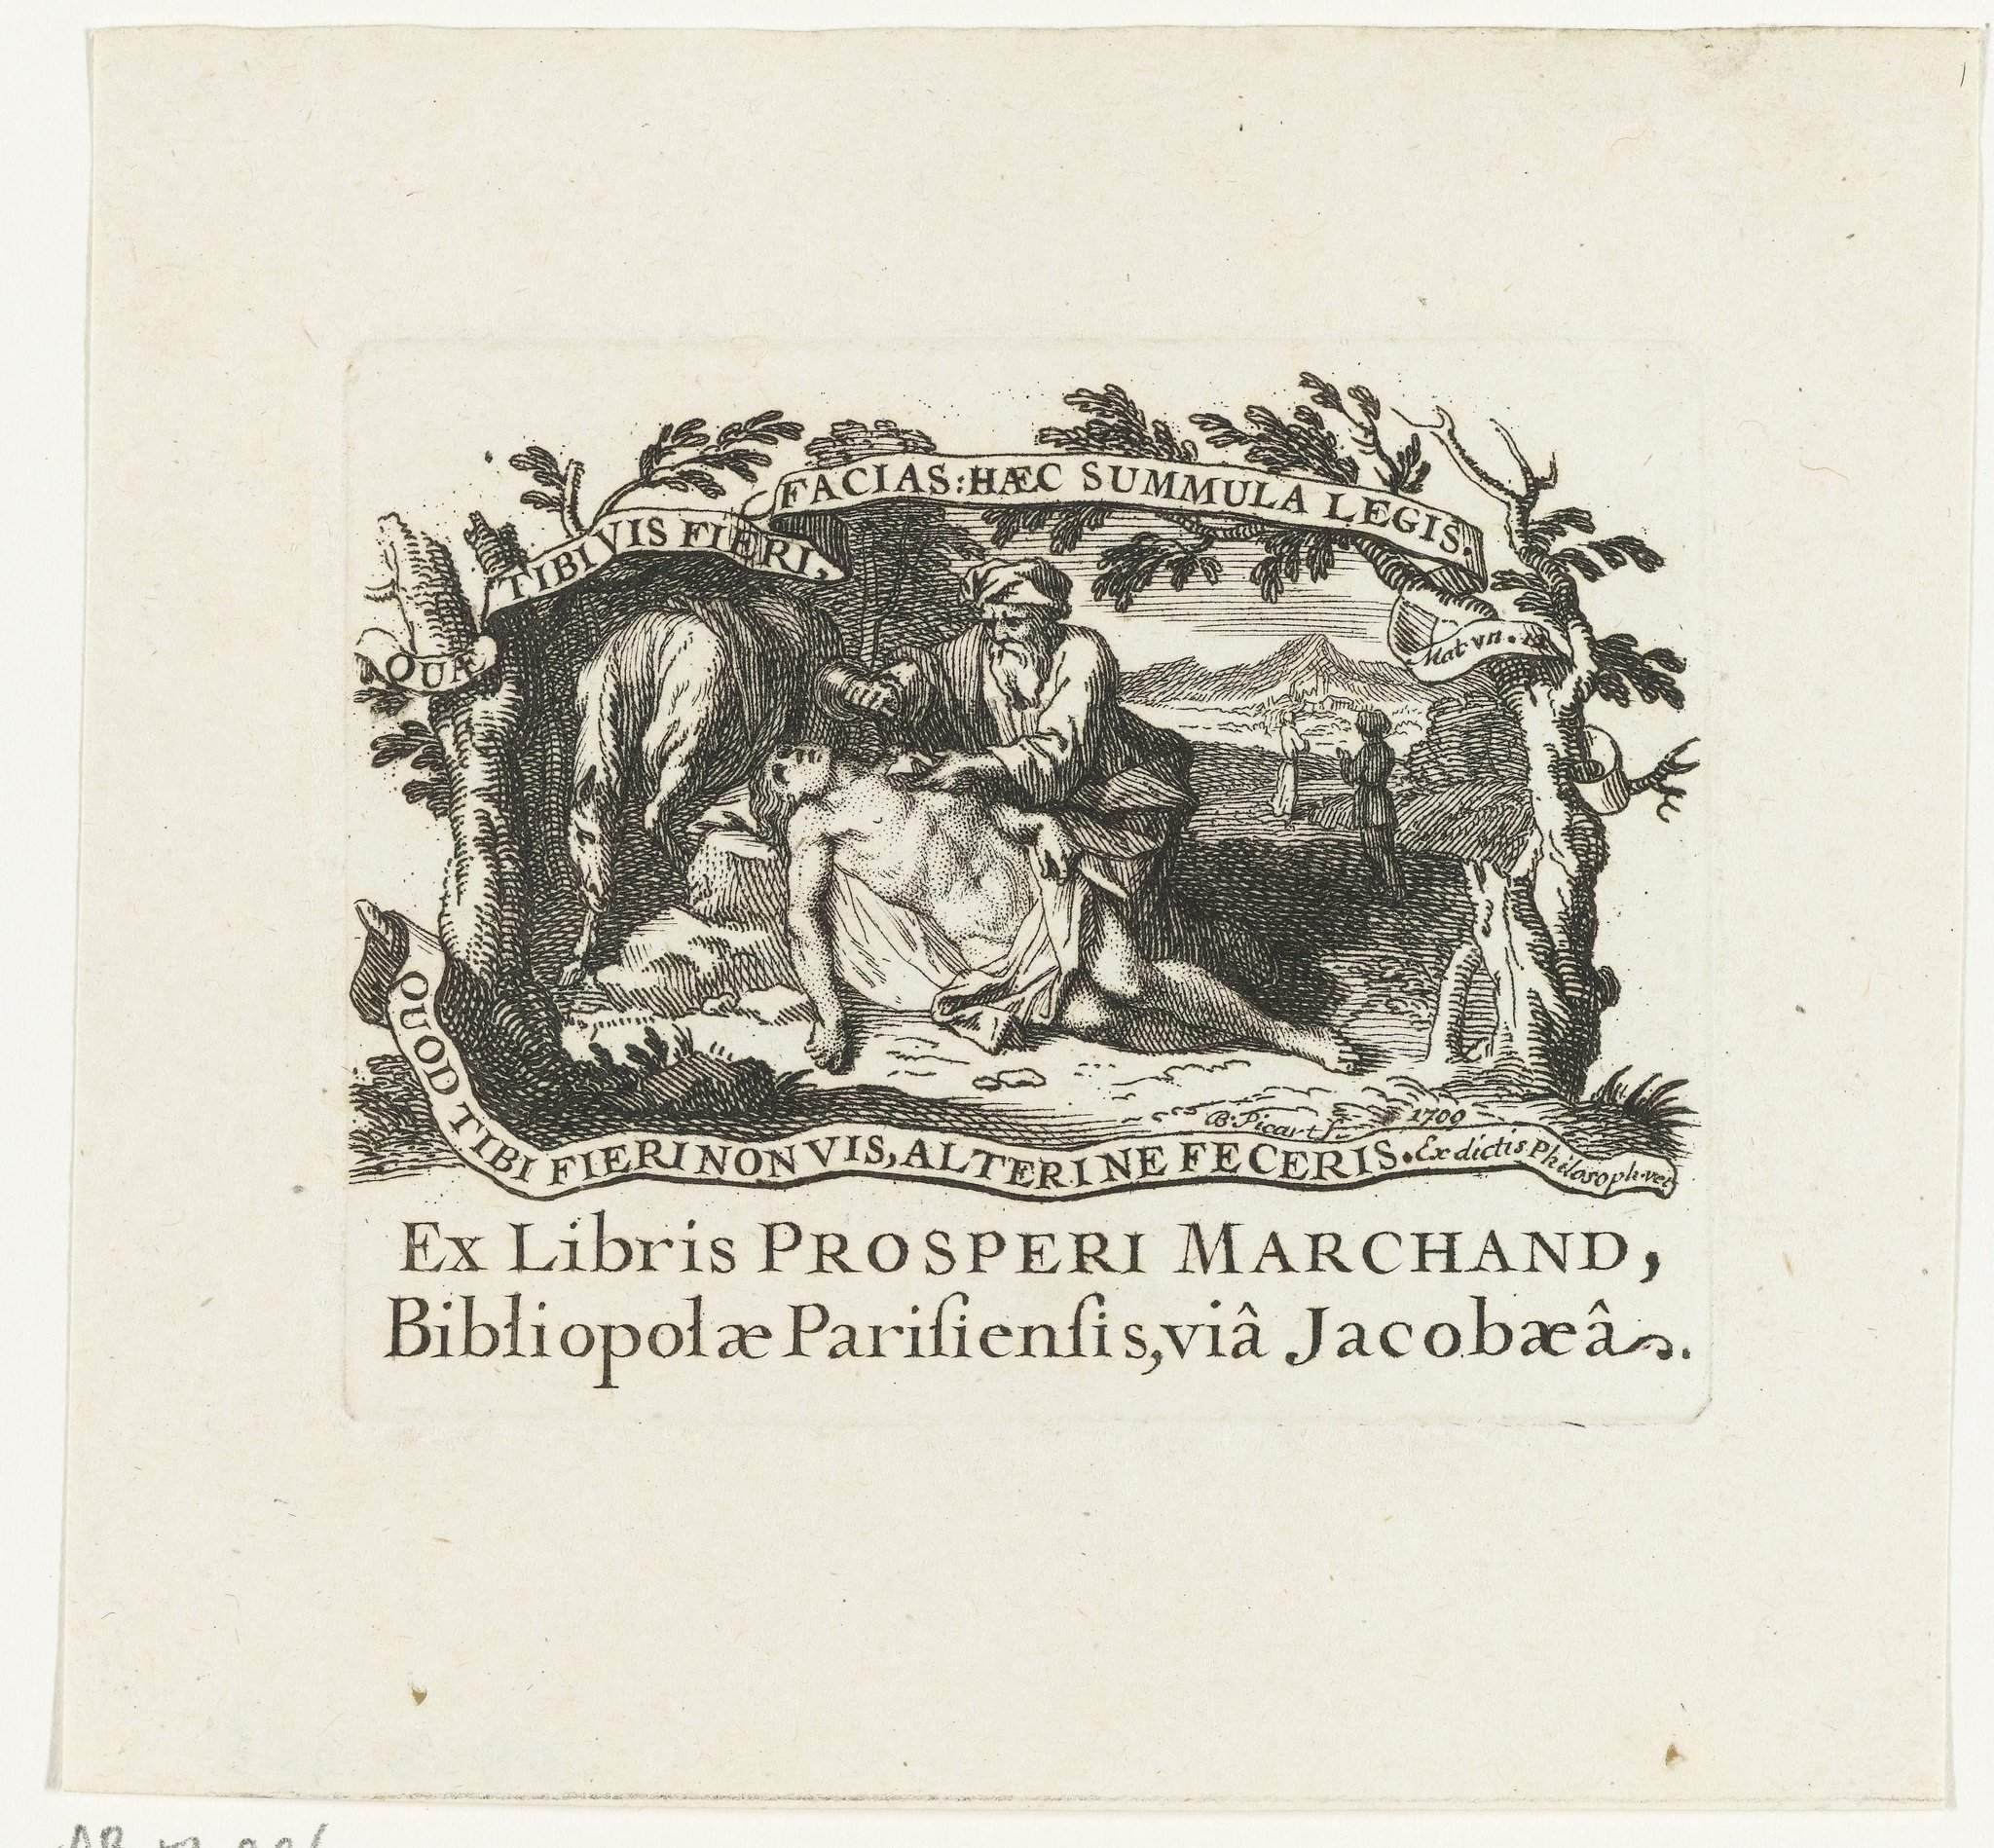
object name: print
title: Barmhartige Samaritaan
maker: bernard picart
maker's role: draughtsman, print maker, publisher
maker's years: 1673-1733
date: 1709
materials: paper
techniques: engraving, etching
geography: paris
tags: publisher, prosper marchand, a samaritan tending the wounds of the traveller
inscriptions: collector's mark: Lugt 2228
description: De barmhartige Samaritaan verzorgt de wonden van de gewonde man. Op de achtergrond lopen de Leviet en de priester, die de man voorbij waren gelopen. Ex-libris van boekverkoper Prosper Marchand.